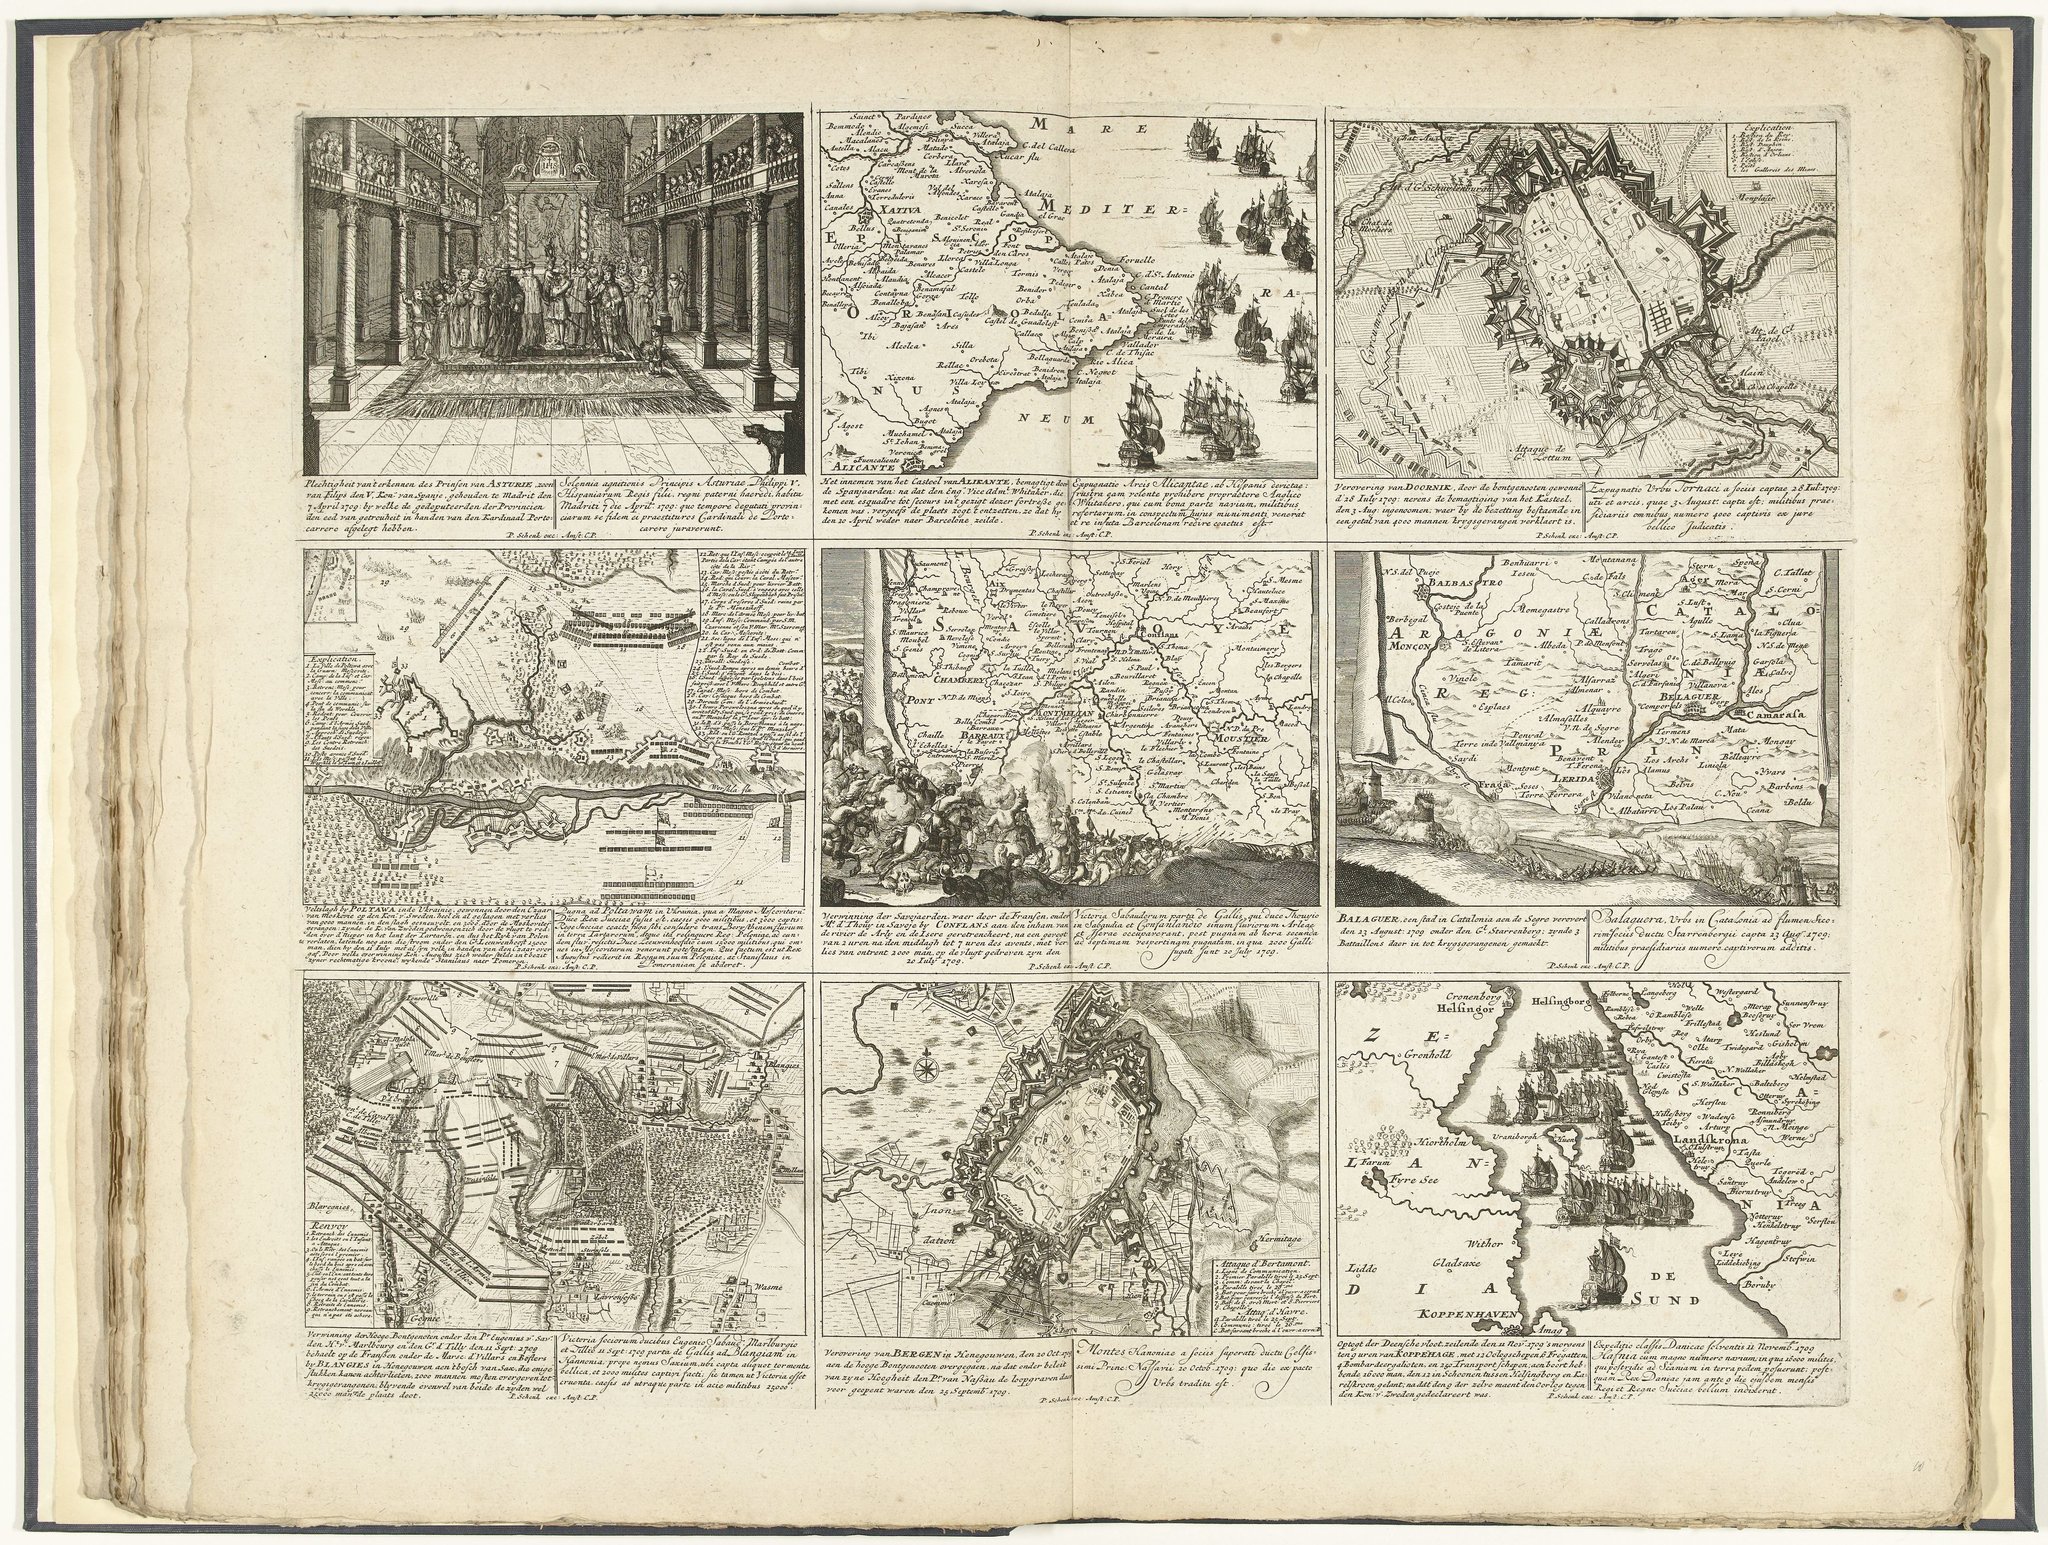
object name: print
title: Schouwtoneel van den oorlog (blad X), 1709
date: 1709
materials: paper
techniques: etching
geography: amsterdam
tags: fortress, maps of separate countries or regions, maps of cities, battle (+ land forces), copenhagen (city)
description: Blad met negen voorstellingen van gebeurtenissen uit het jaar 1709 van de Spaanse Successieoorlog en van plattegronden van versterkte steden. Opschriften in de voorstelling in het Nederlands en Latijn. Plaat 9 in het prentwerk met de gebundelde reeks van 33 platen met voorstellingen (het merendeel verdeeld in 9 kleinere scènes) van gebeurtenissen uit de jaren 1700-1727 van de Spaanse Successieoorlog en de jaren daarna, kaarten en plattegronden.